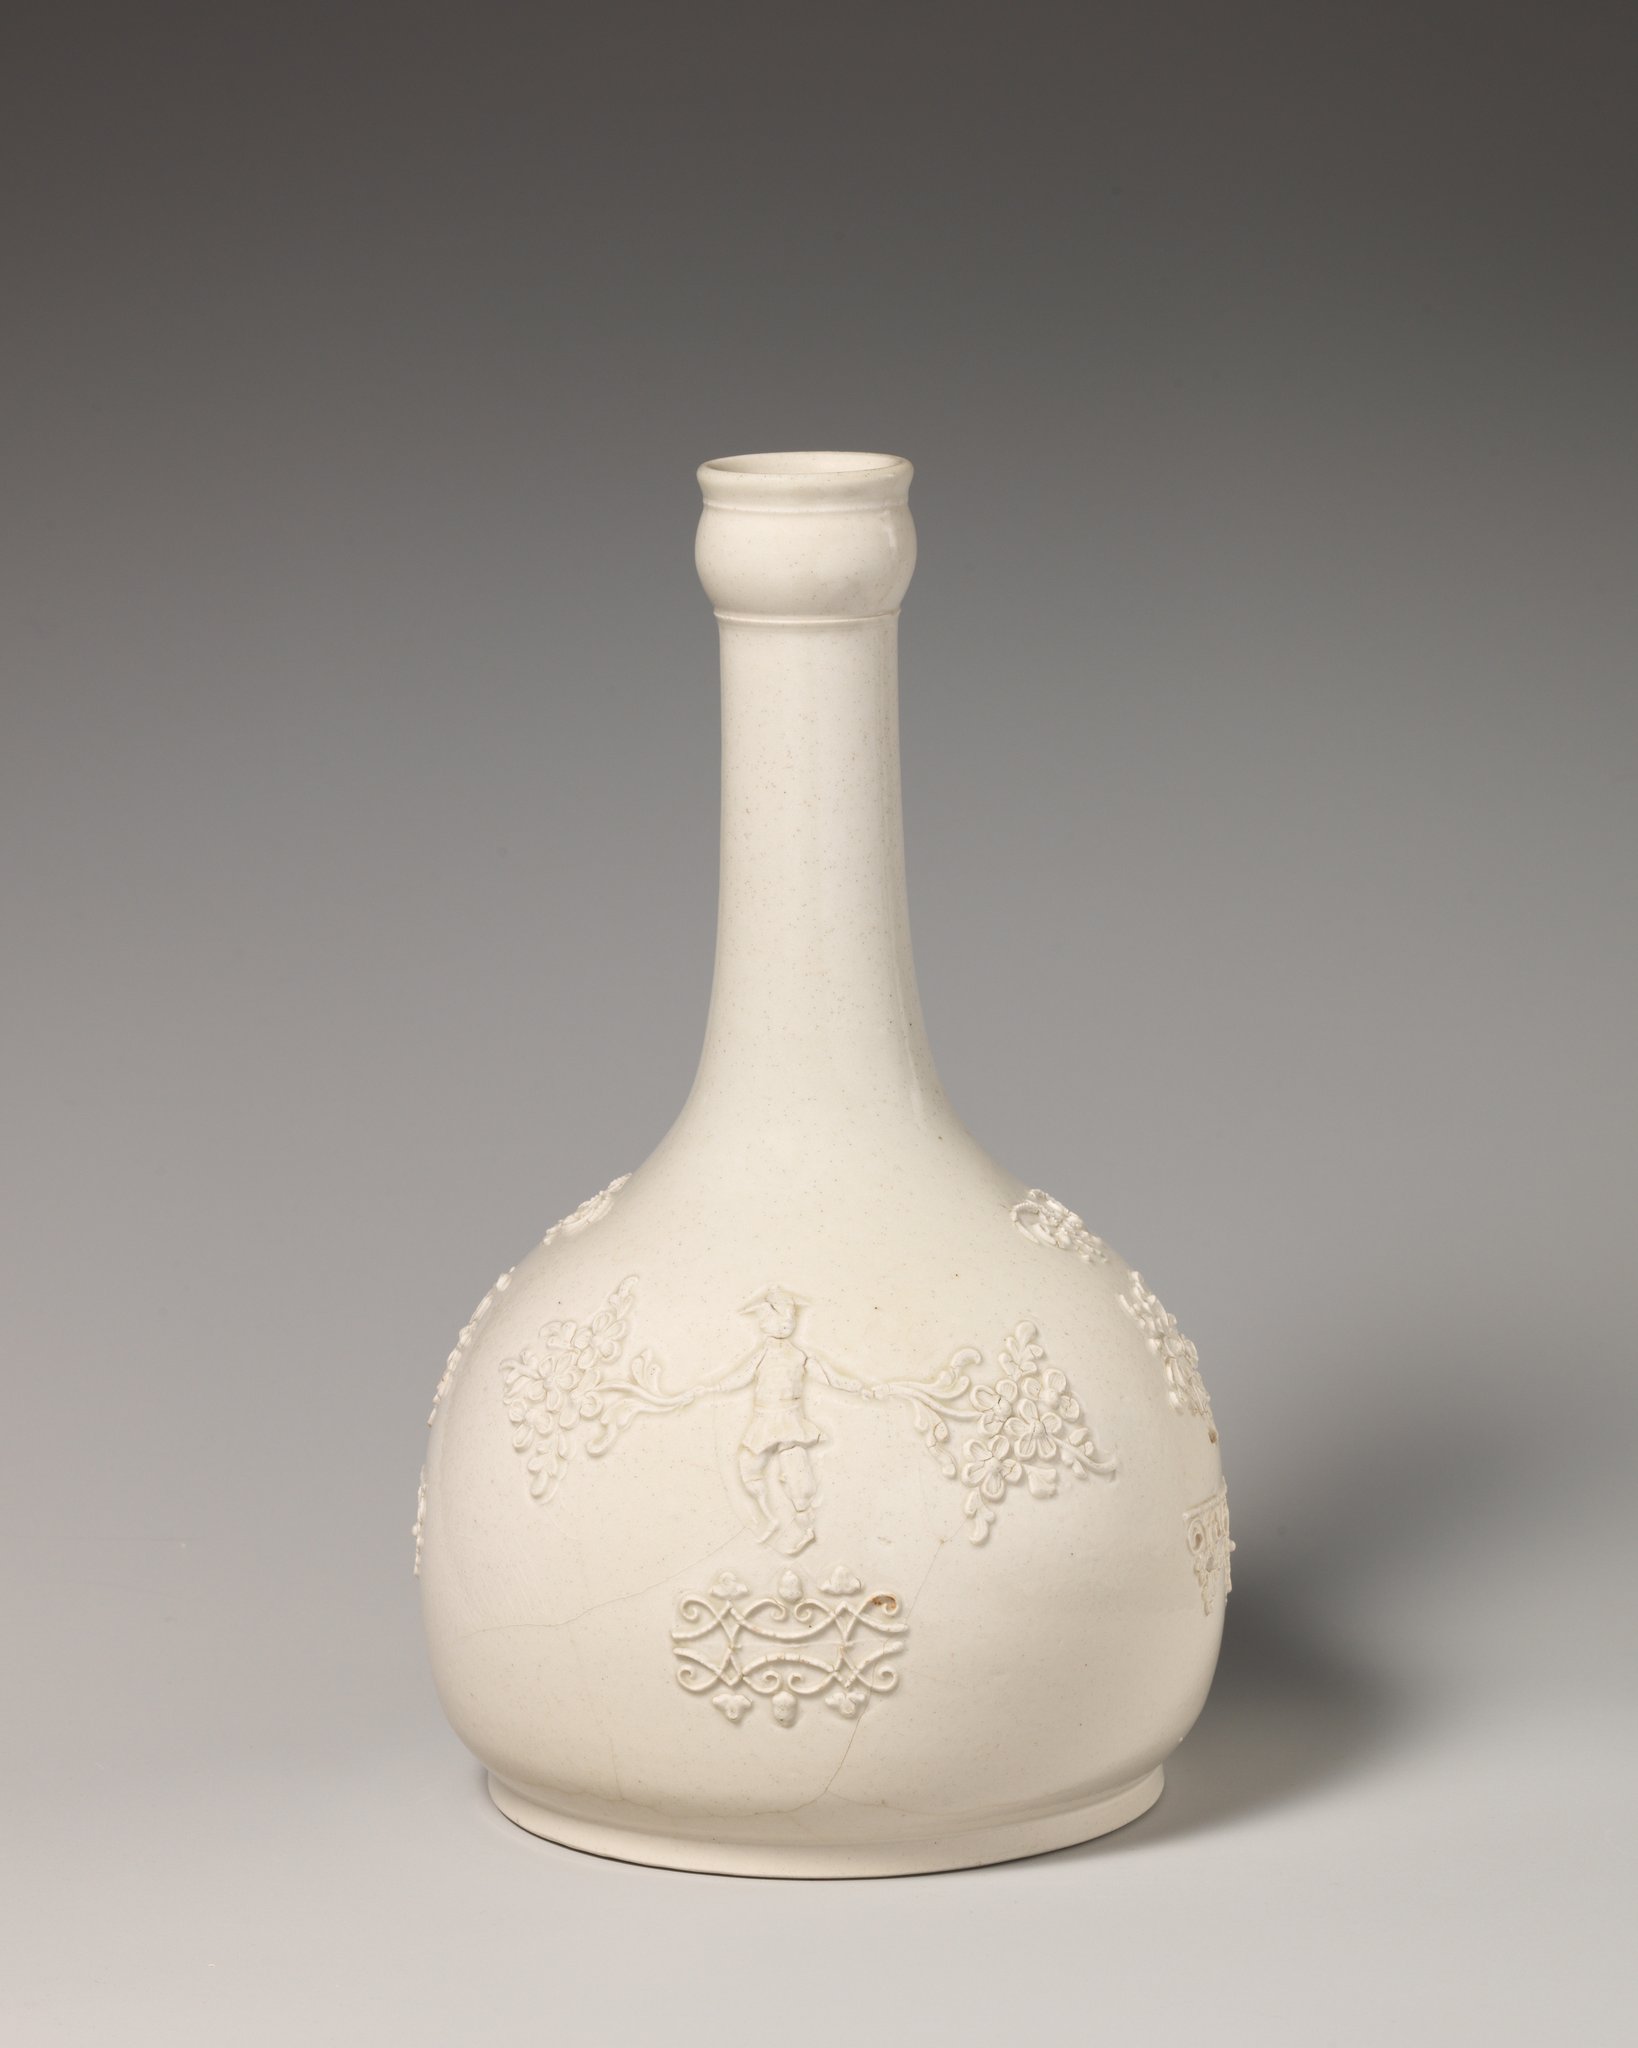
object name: water bottle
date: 1755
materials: stoneware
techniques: salt glaze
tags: human figures